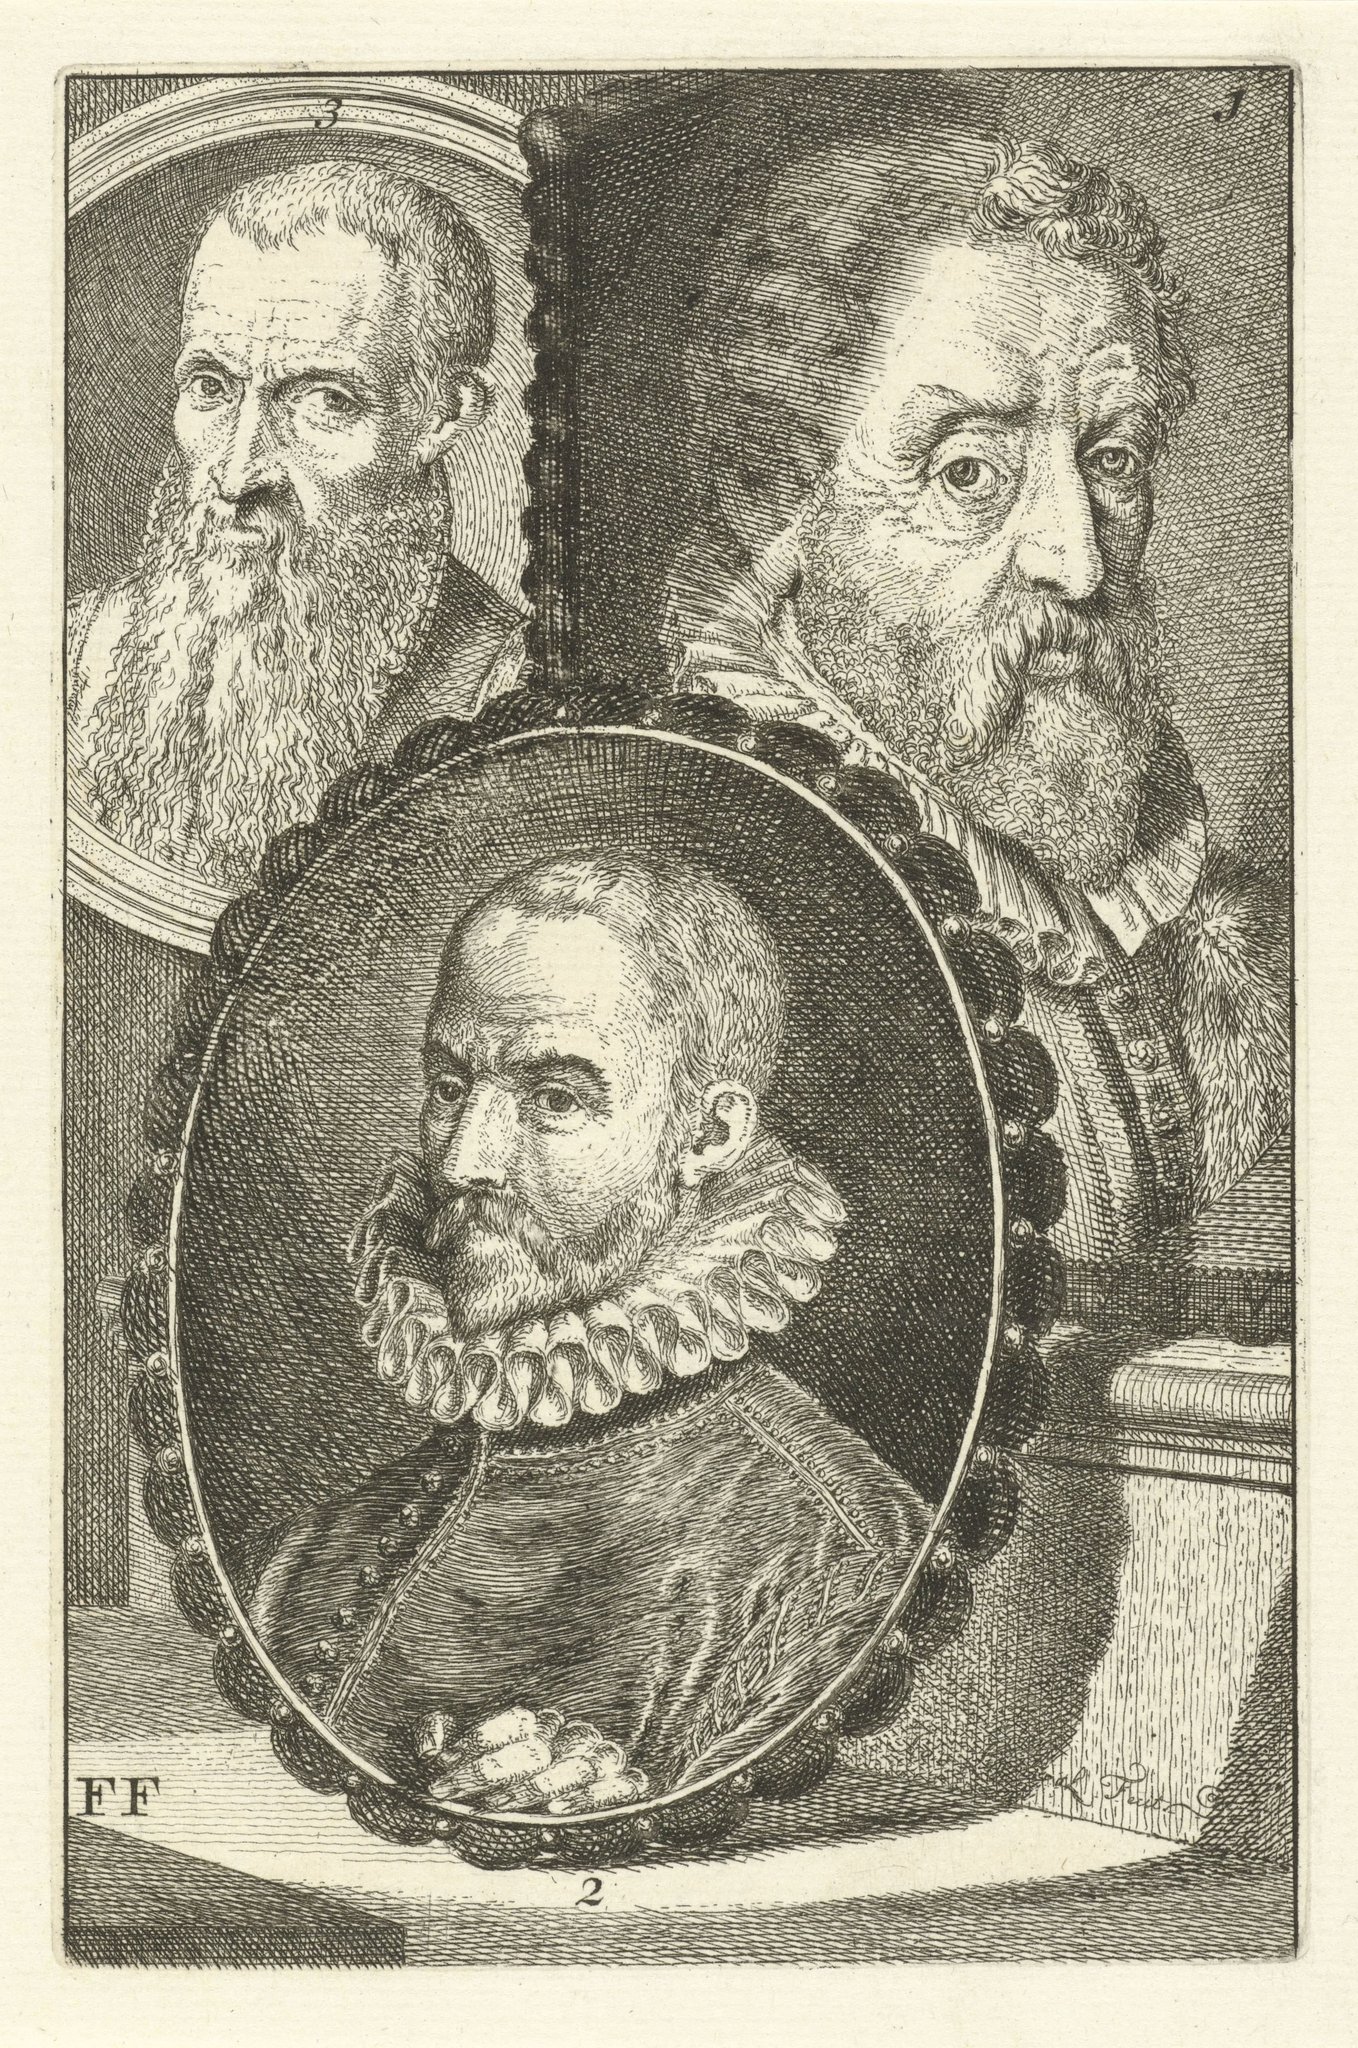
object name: print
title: Portretten van Maerten de Vos, Jan van der Straet en Jan Gols van Kaiserswerth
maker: jan l admiral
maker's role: draughtsman, print maker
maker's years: 1699-1773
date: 1764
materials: paper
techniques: etching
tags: bruges, jan van der straet, antwerp, painter, draughtsman, maerten de vos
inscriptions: collector's mark: Lugt 2228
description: Prent opgenomen in: Mander, Karel van; Jongh, Jacobus de (vert.). Het leven der doorluchtige Nederlandsche en eenige Hoogduitsche schilders. Amsterdam: Steven van Esveldt, 1764.